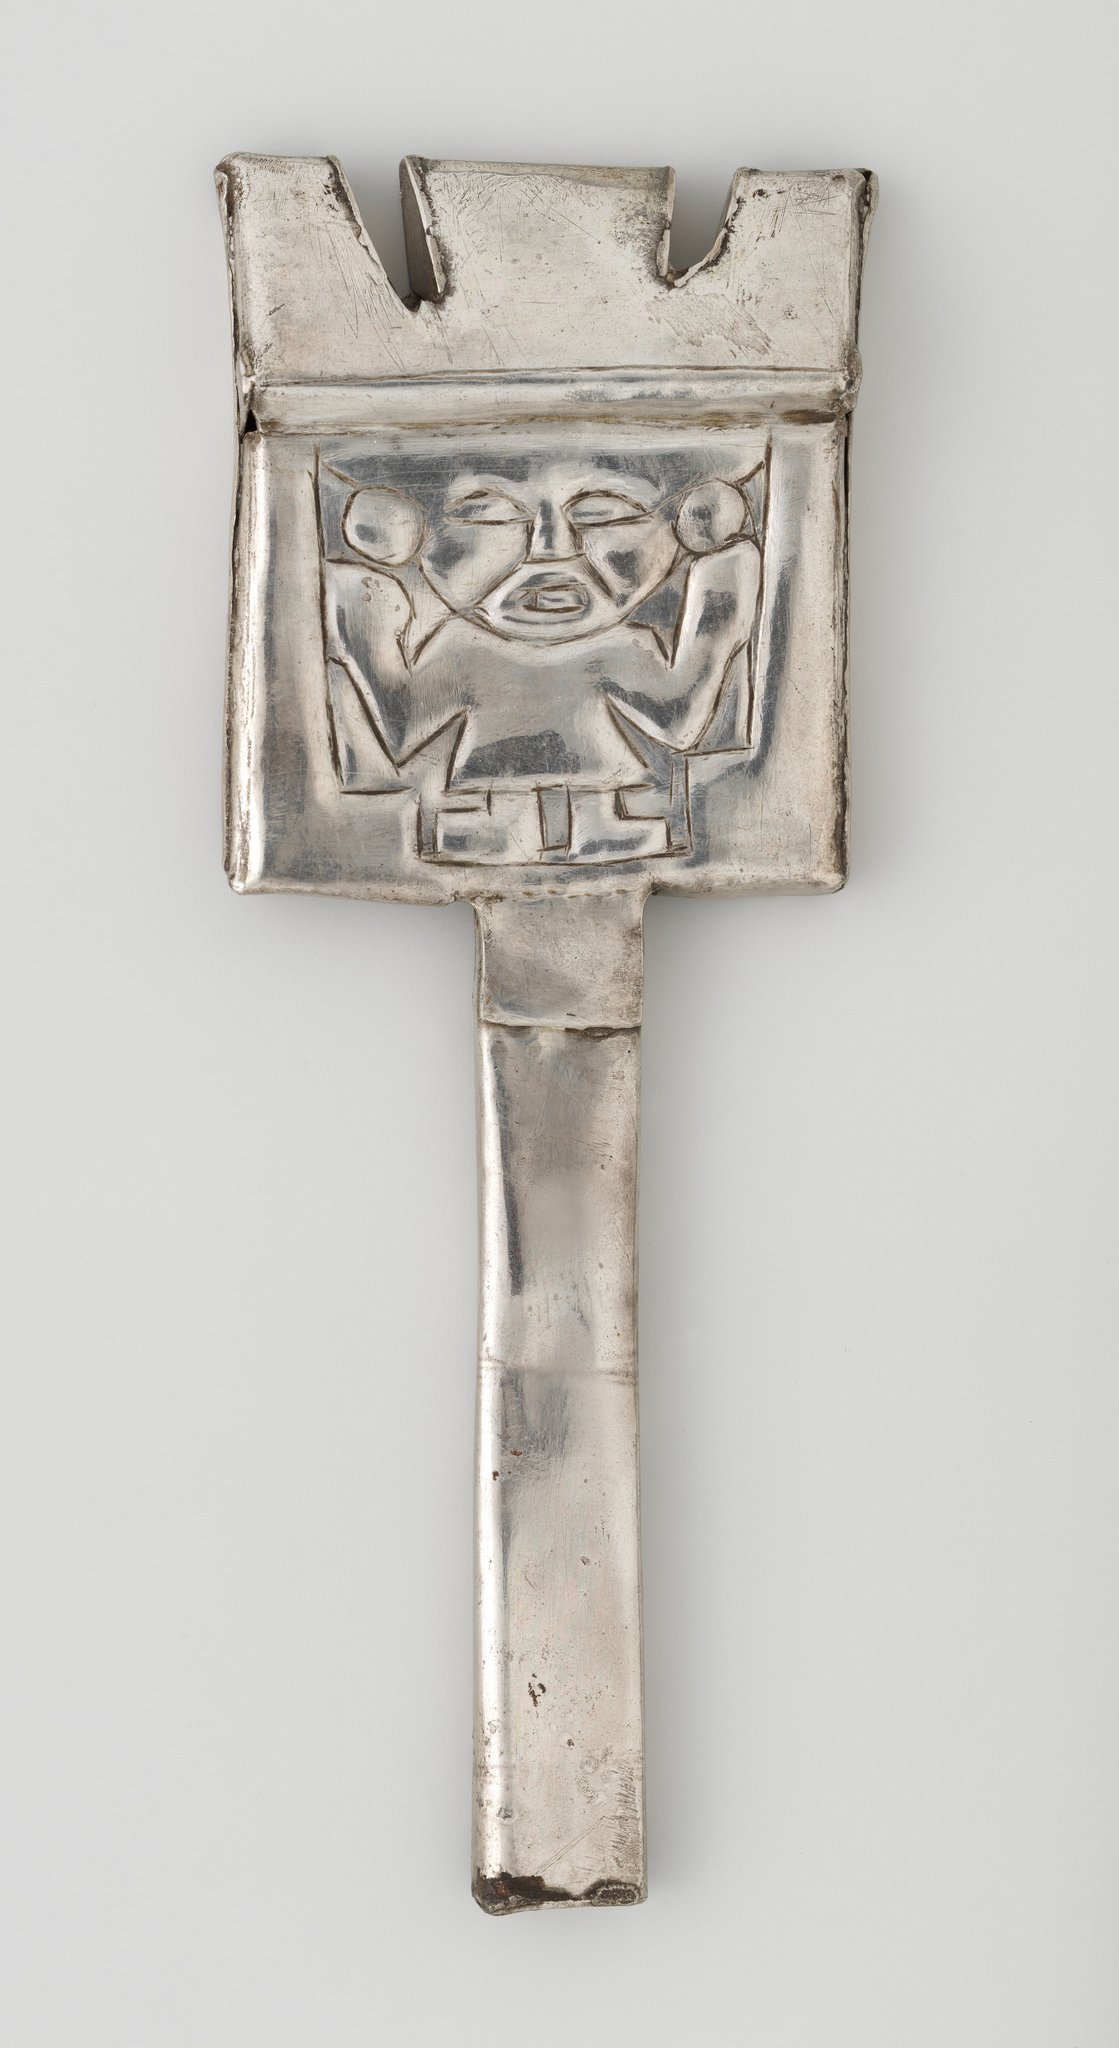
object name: mirror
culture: chancay or chimú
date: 1201-1500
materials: silver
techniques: hammering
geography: peru